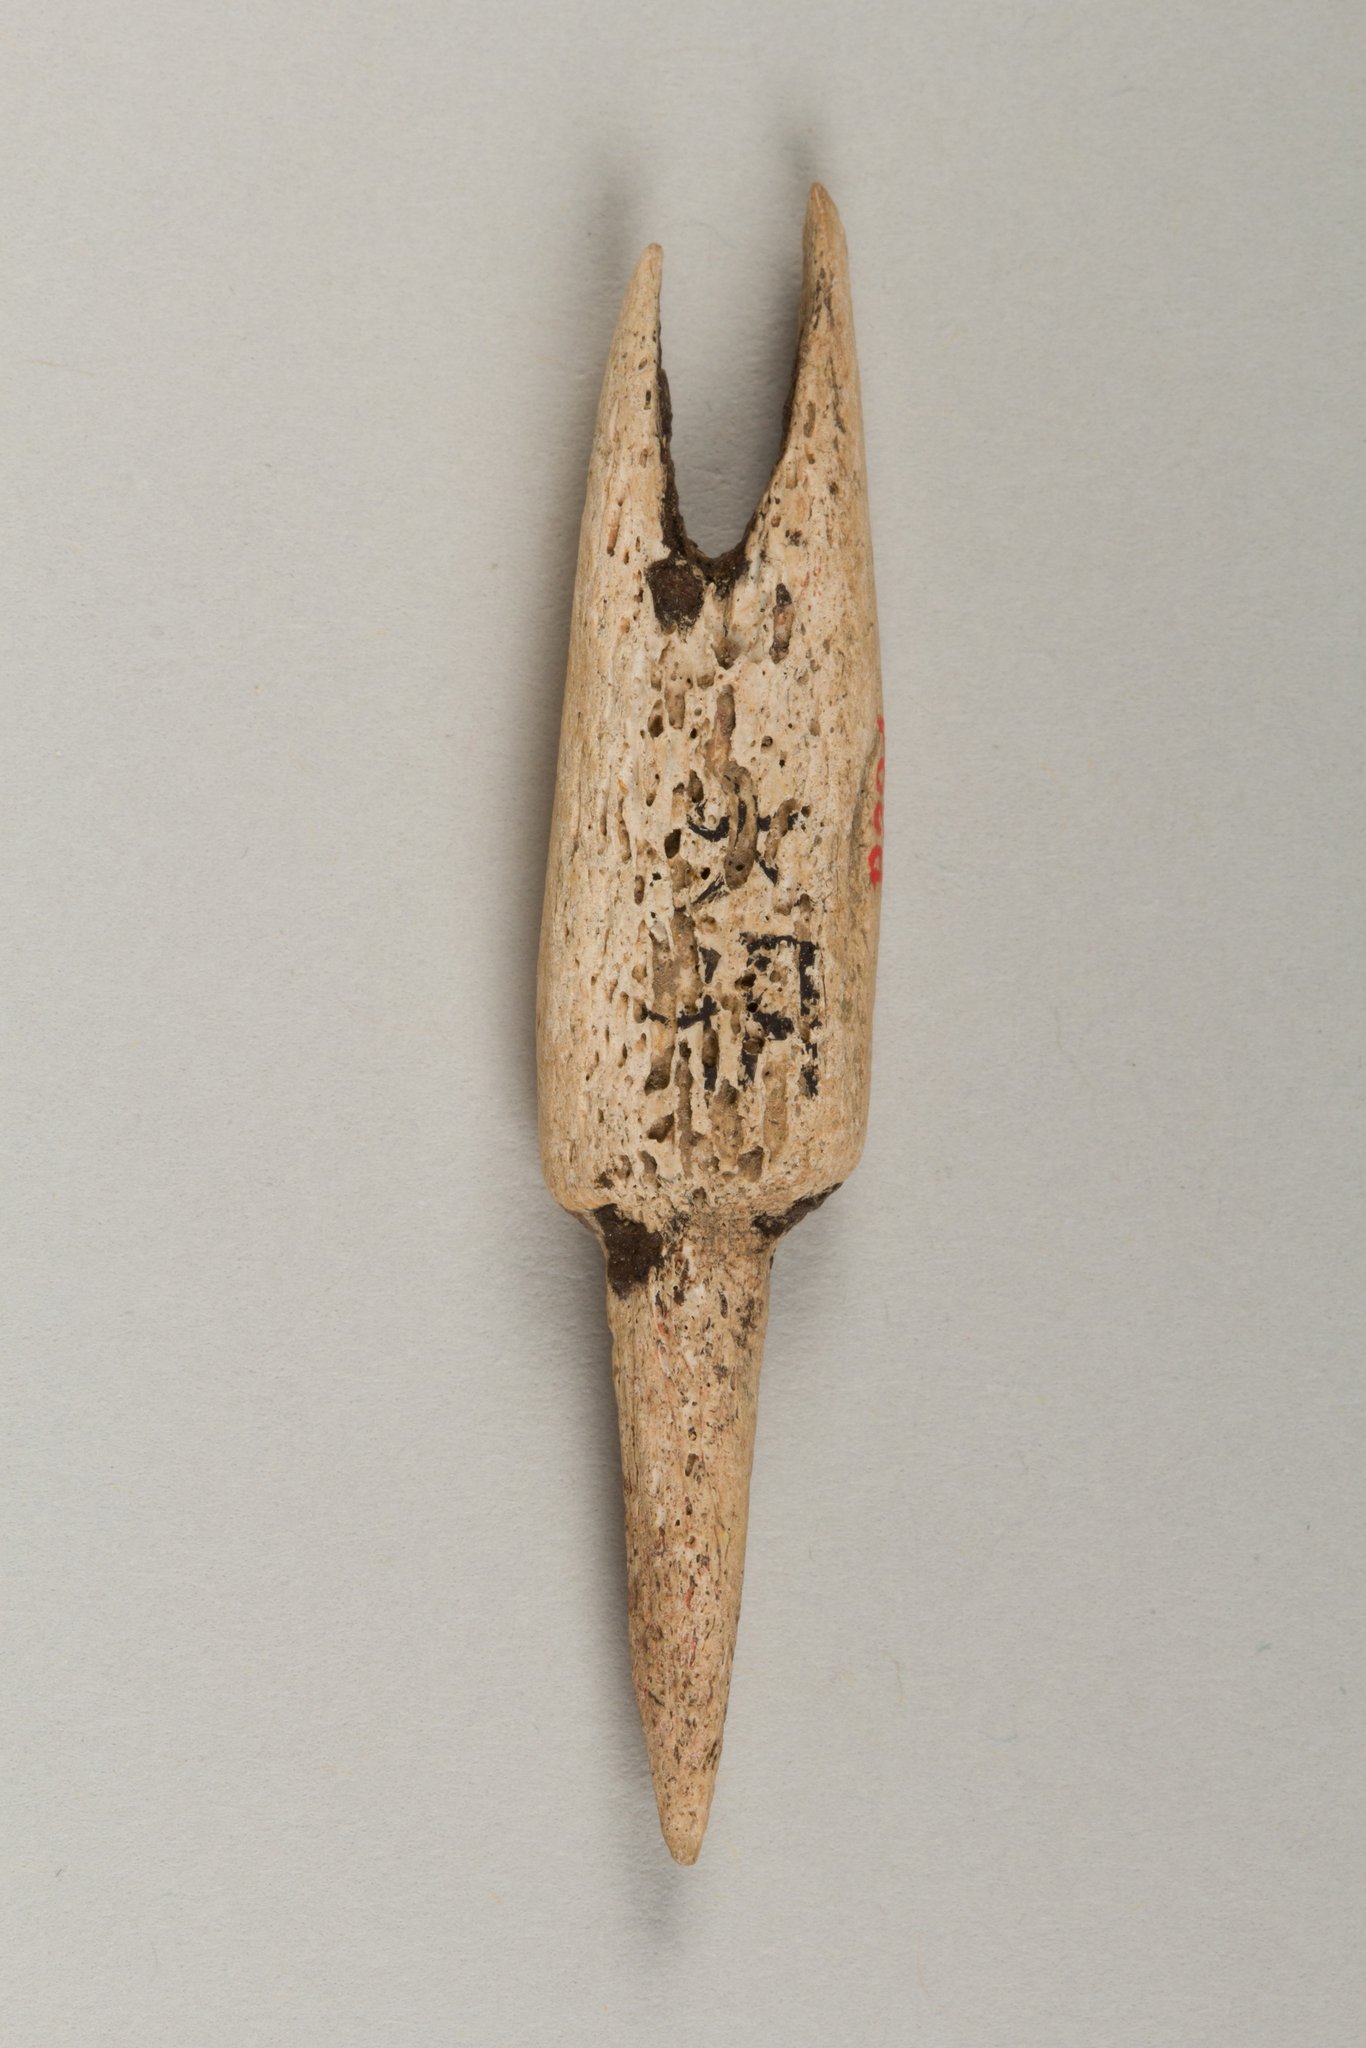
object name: arrowhead grip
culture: japanese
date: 1000-300 BCE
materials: bone